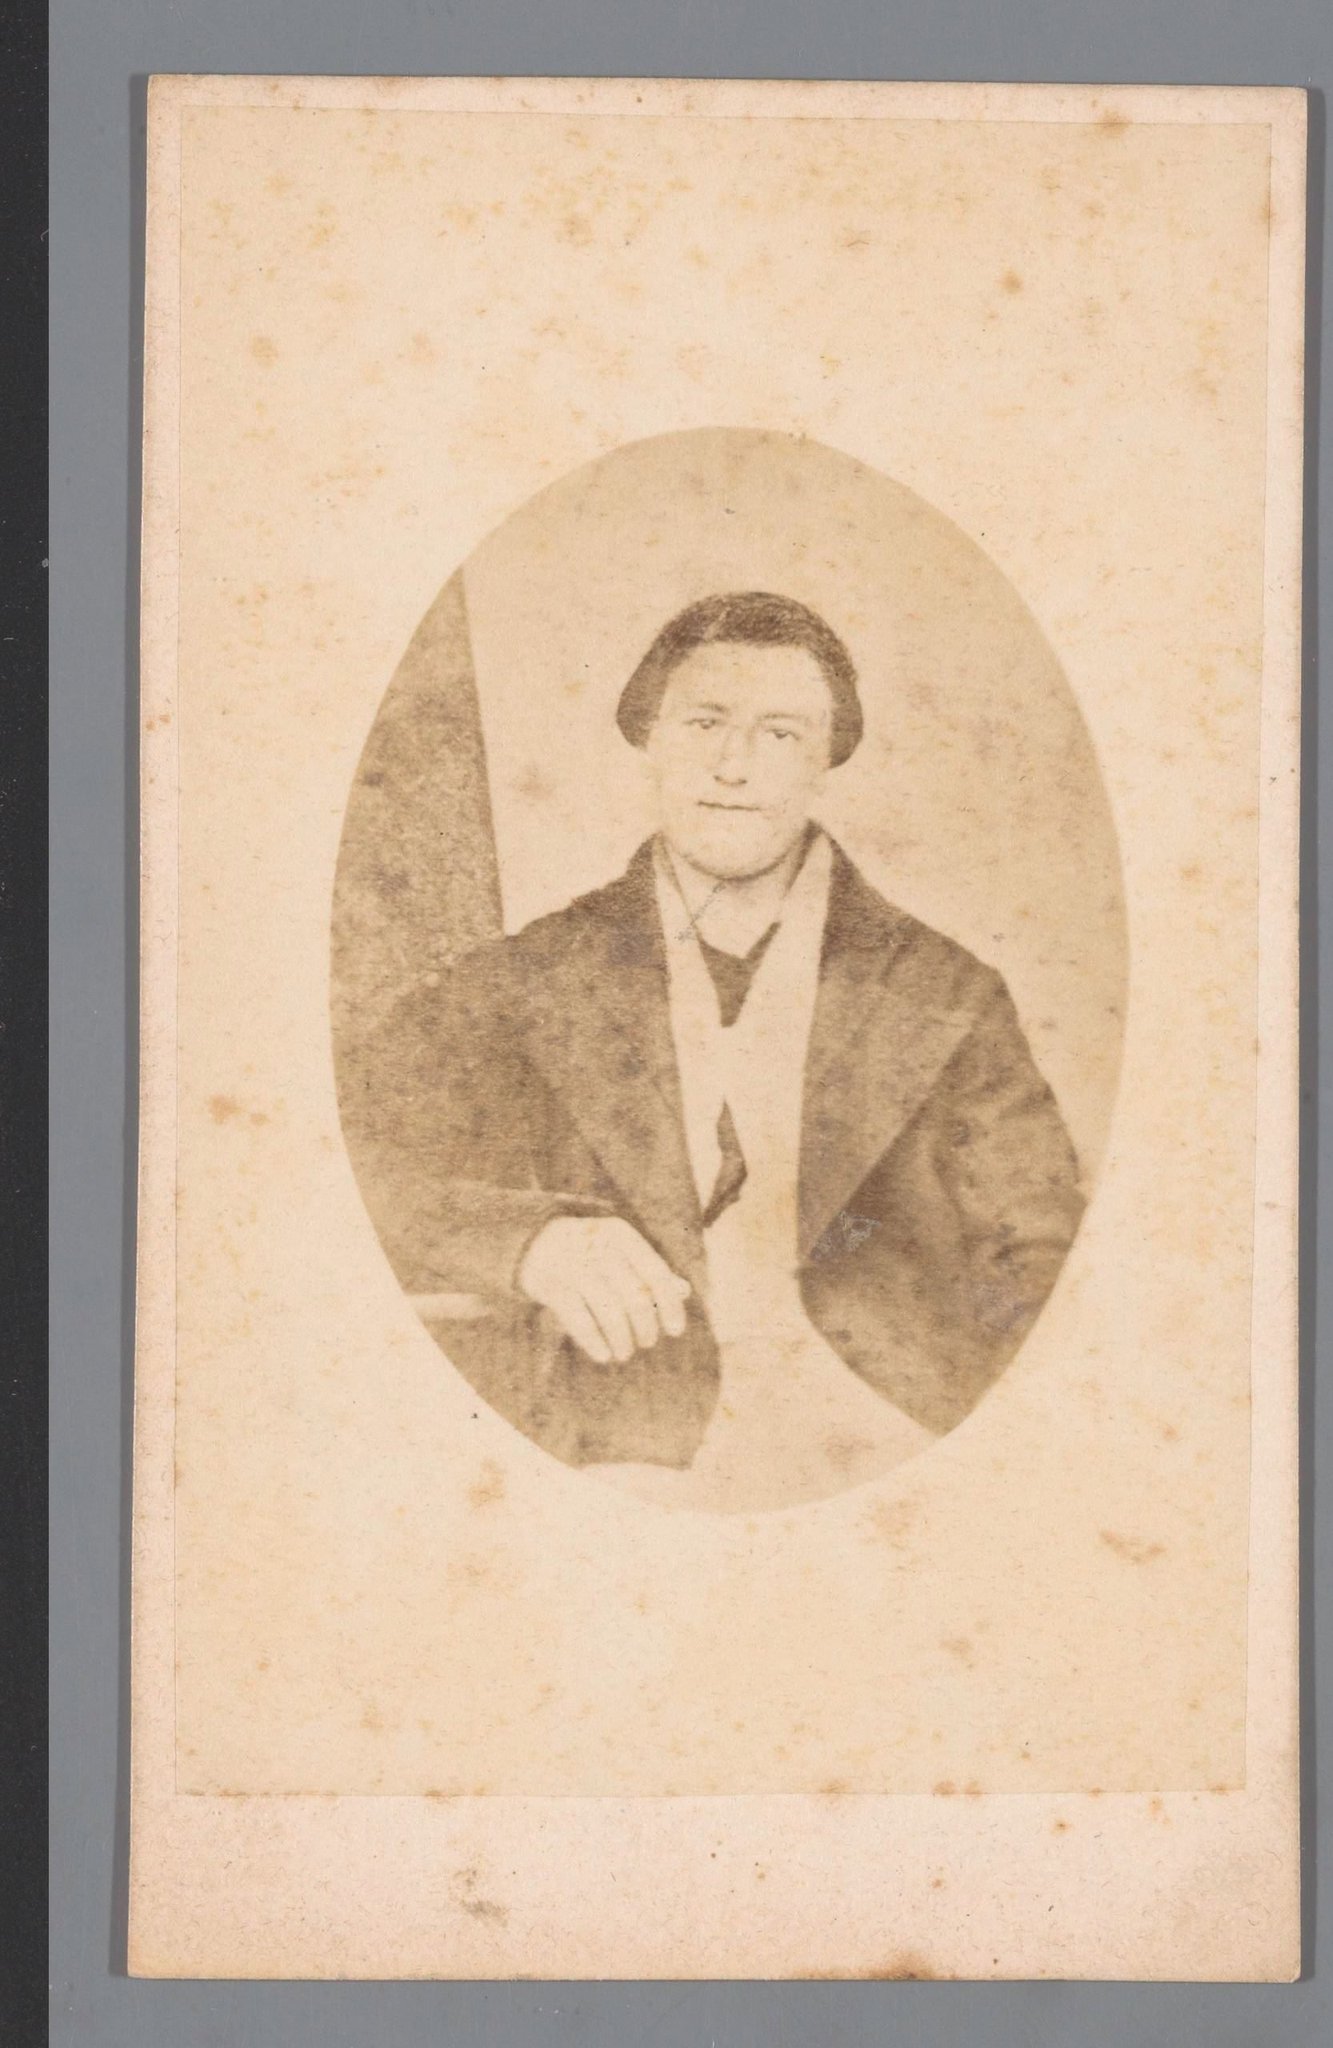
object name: carte de visite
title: Portret van een man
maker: benjamin van der heide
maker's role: fotograaf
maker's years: 1837-1928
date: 1850-1900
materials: cardboard, paper, photographic support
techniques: albumen print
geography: harlingen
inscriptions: annotation: ‘De plaat blijft tot nabestelling bewaard’, signature and address: ‘Photographie/van/B. van der Heide/bijde Westerkerk/Harlingen’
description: Zittende man, ten halven lijve, in ovaal